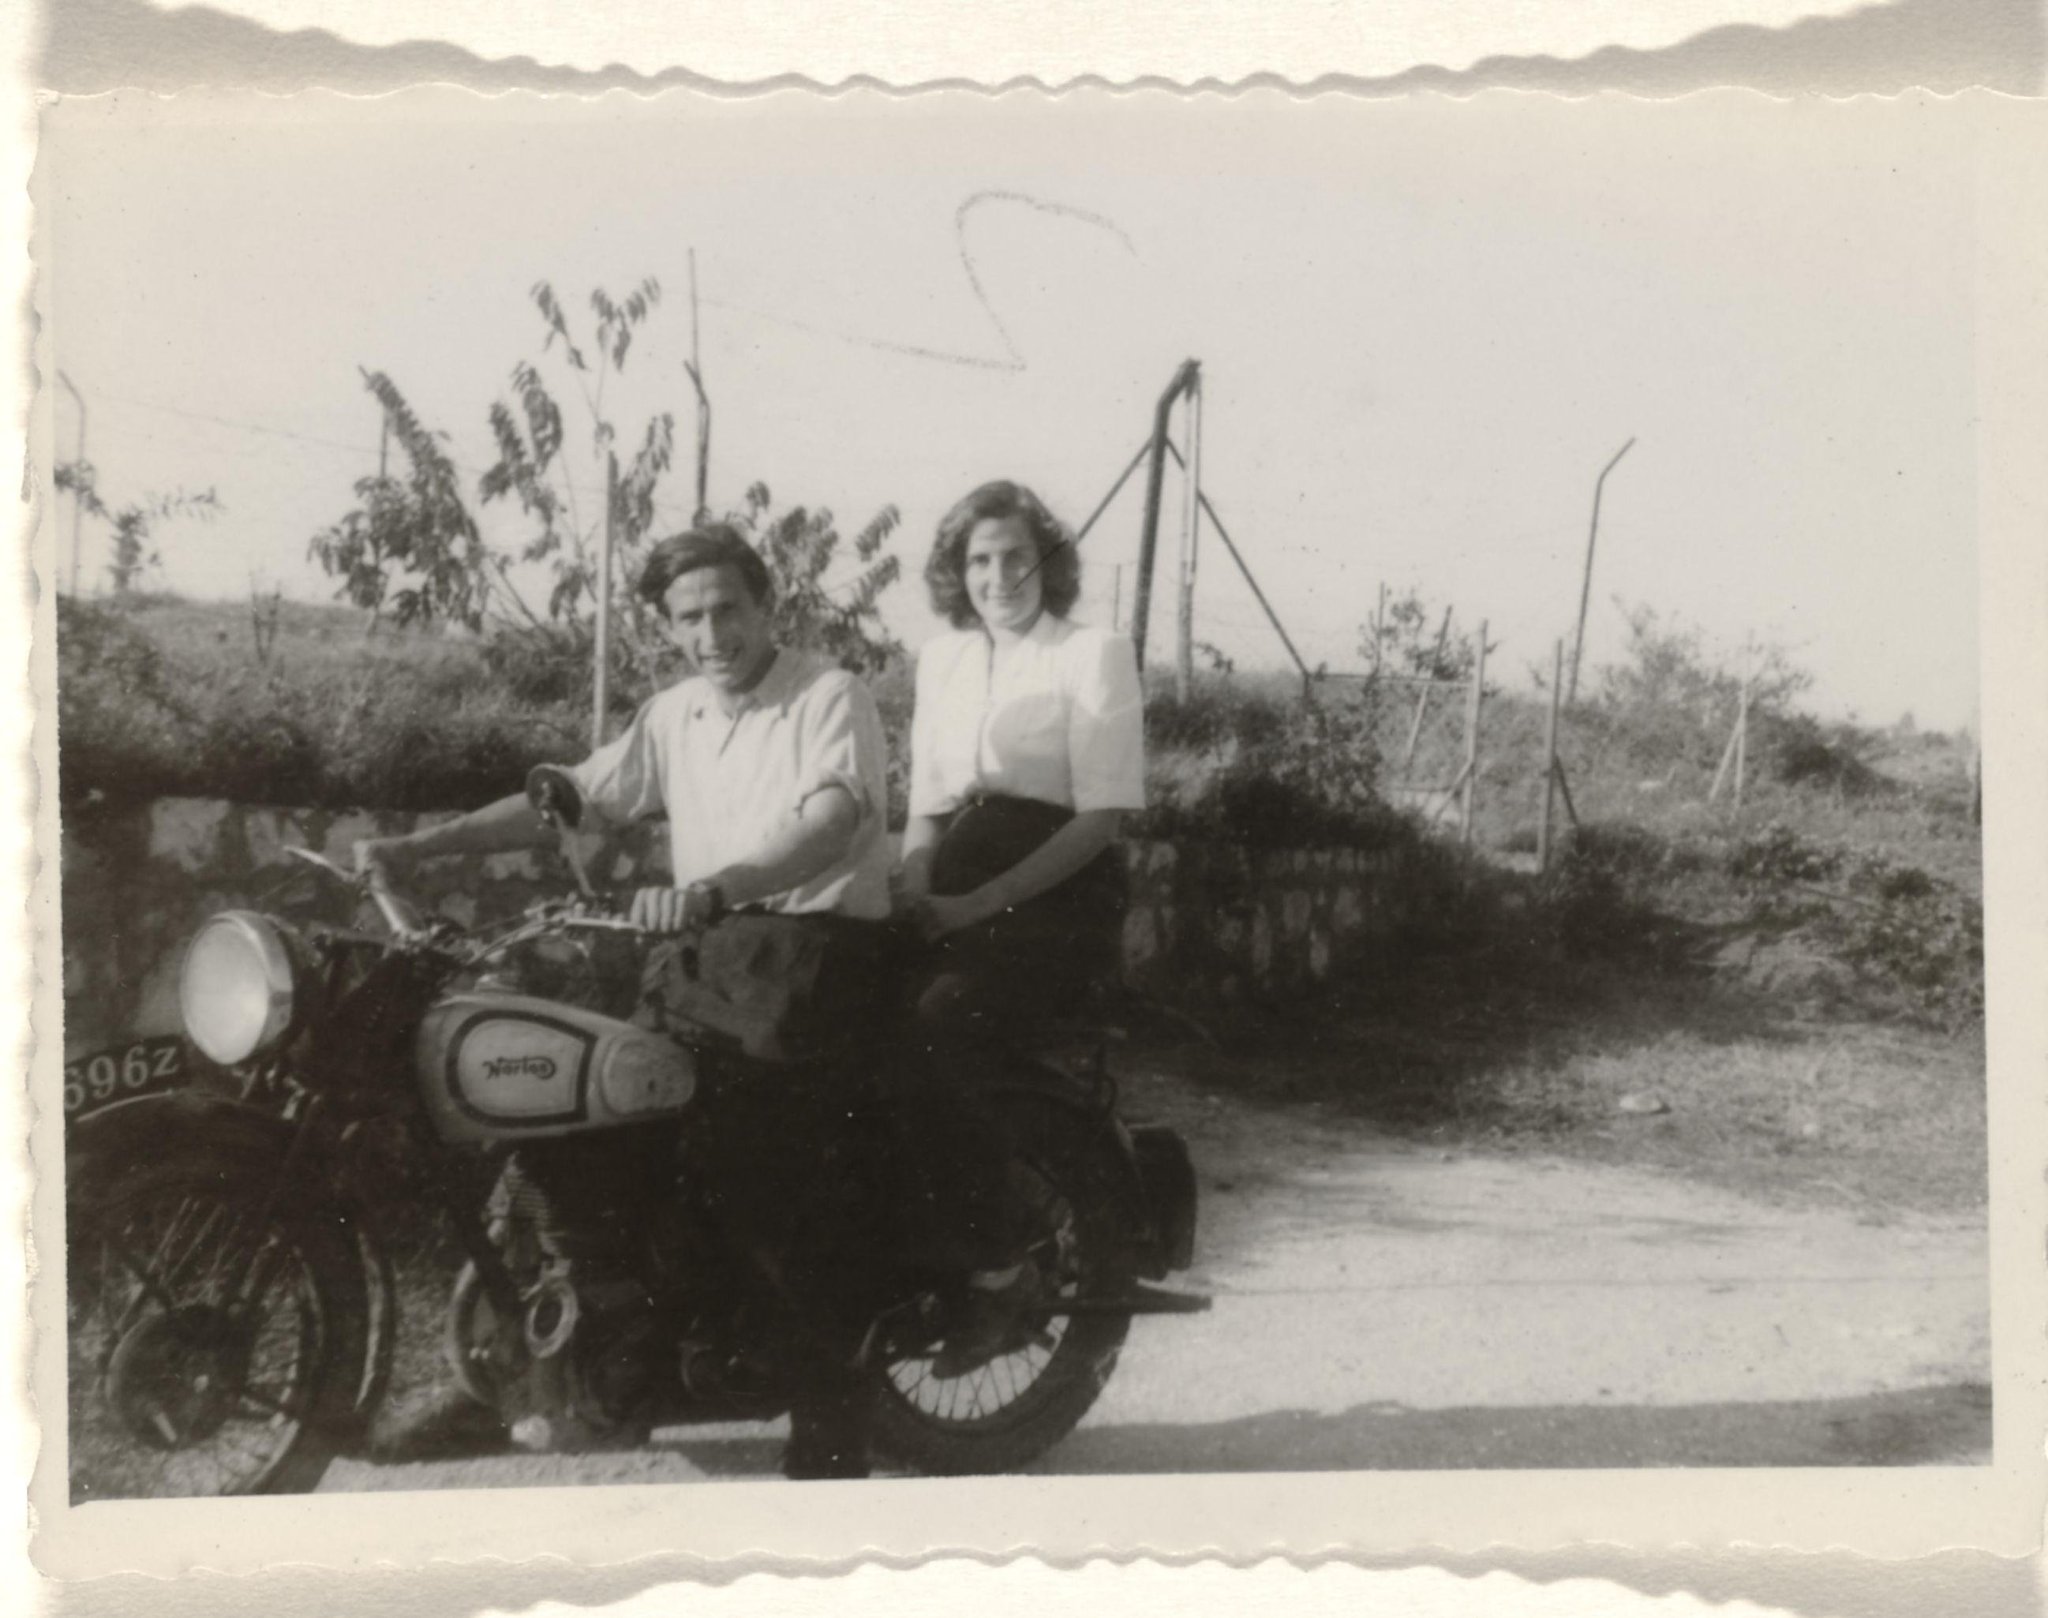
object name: photograph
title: Leo Blumensohn en Isabel Wachenheimer gezeten op een motor, staand voor een hek en een begroeide helling, 1945-1949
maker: Anonymous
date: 1945-1949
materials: photographic support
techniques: gelatin silver print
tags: leiden, isabel wachenheimer-elon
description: Leo Blumensohn en Isabel Wachenheimer gezeten op een motor, staand voor een hek en een begroeide helling.